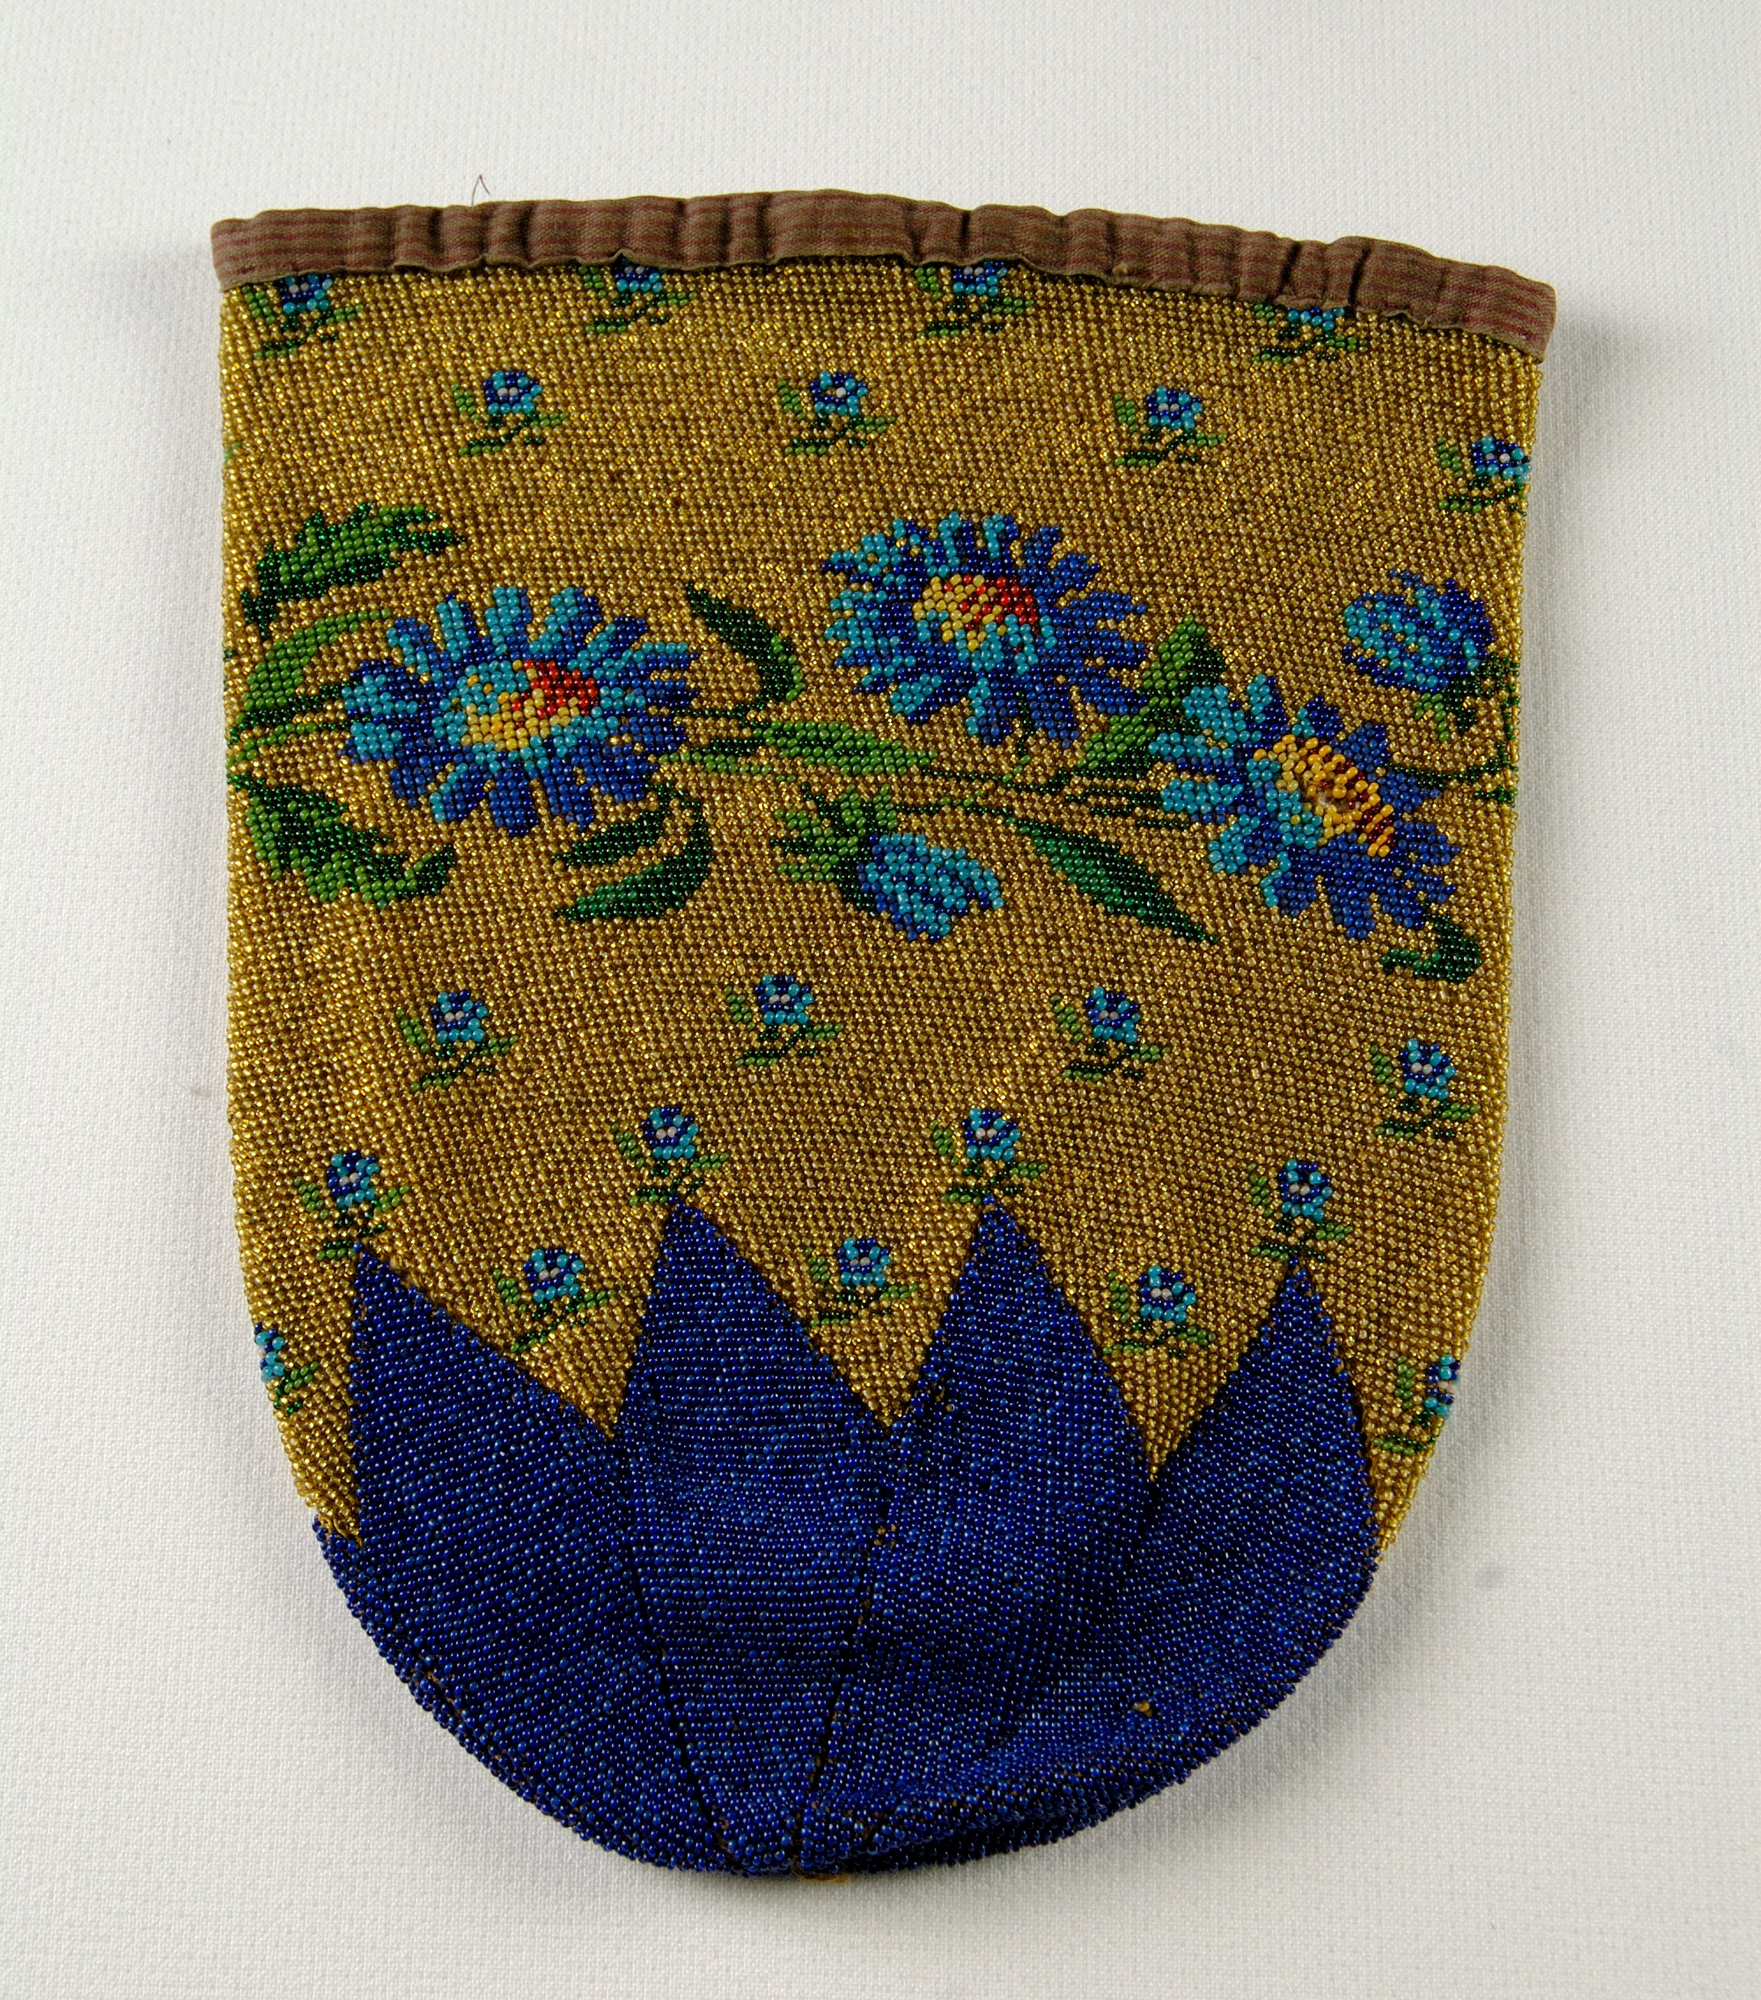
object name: pouch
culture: german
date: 1830-1860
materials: glass, leather, linen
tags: flowers